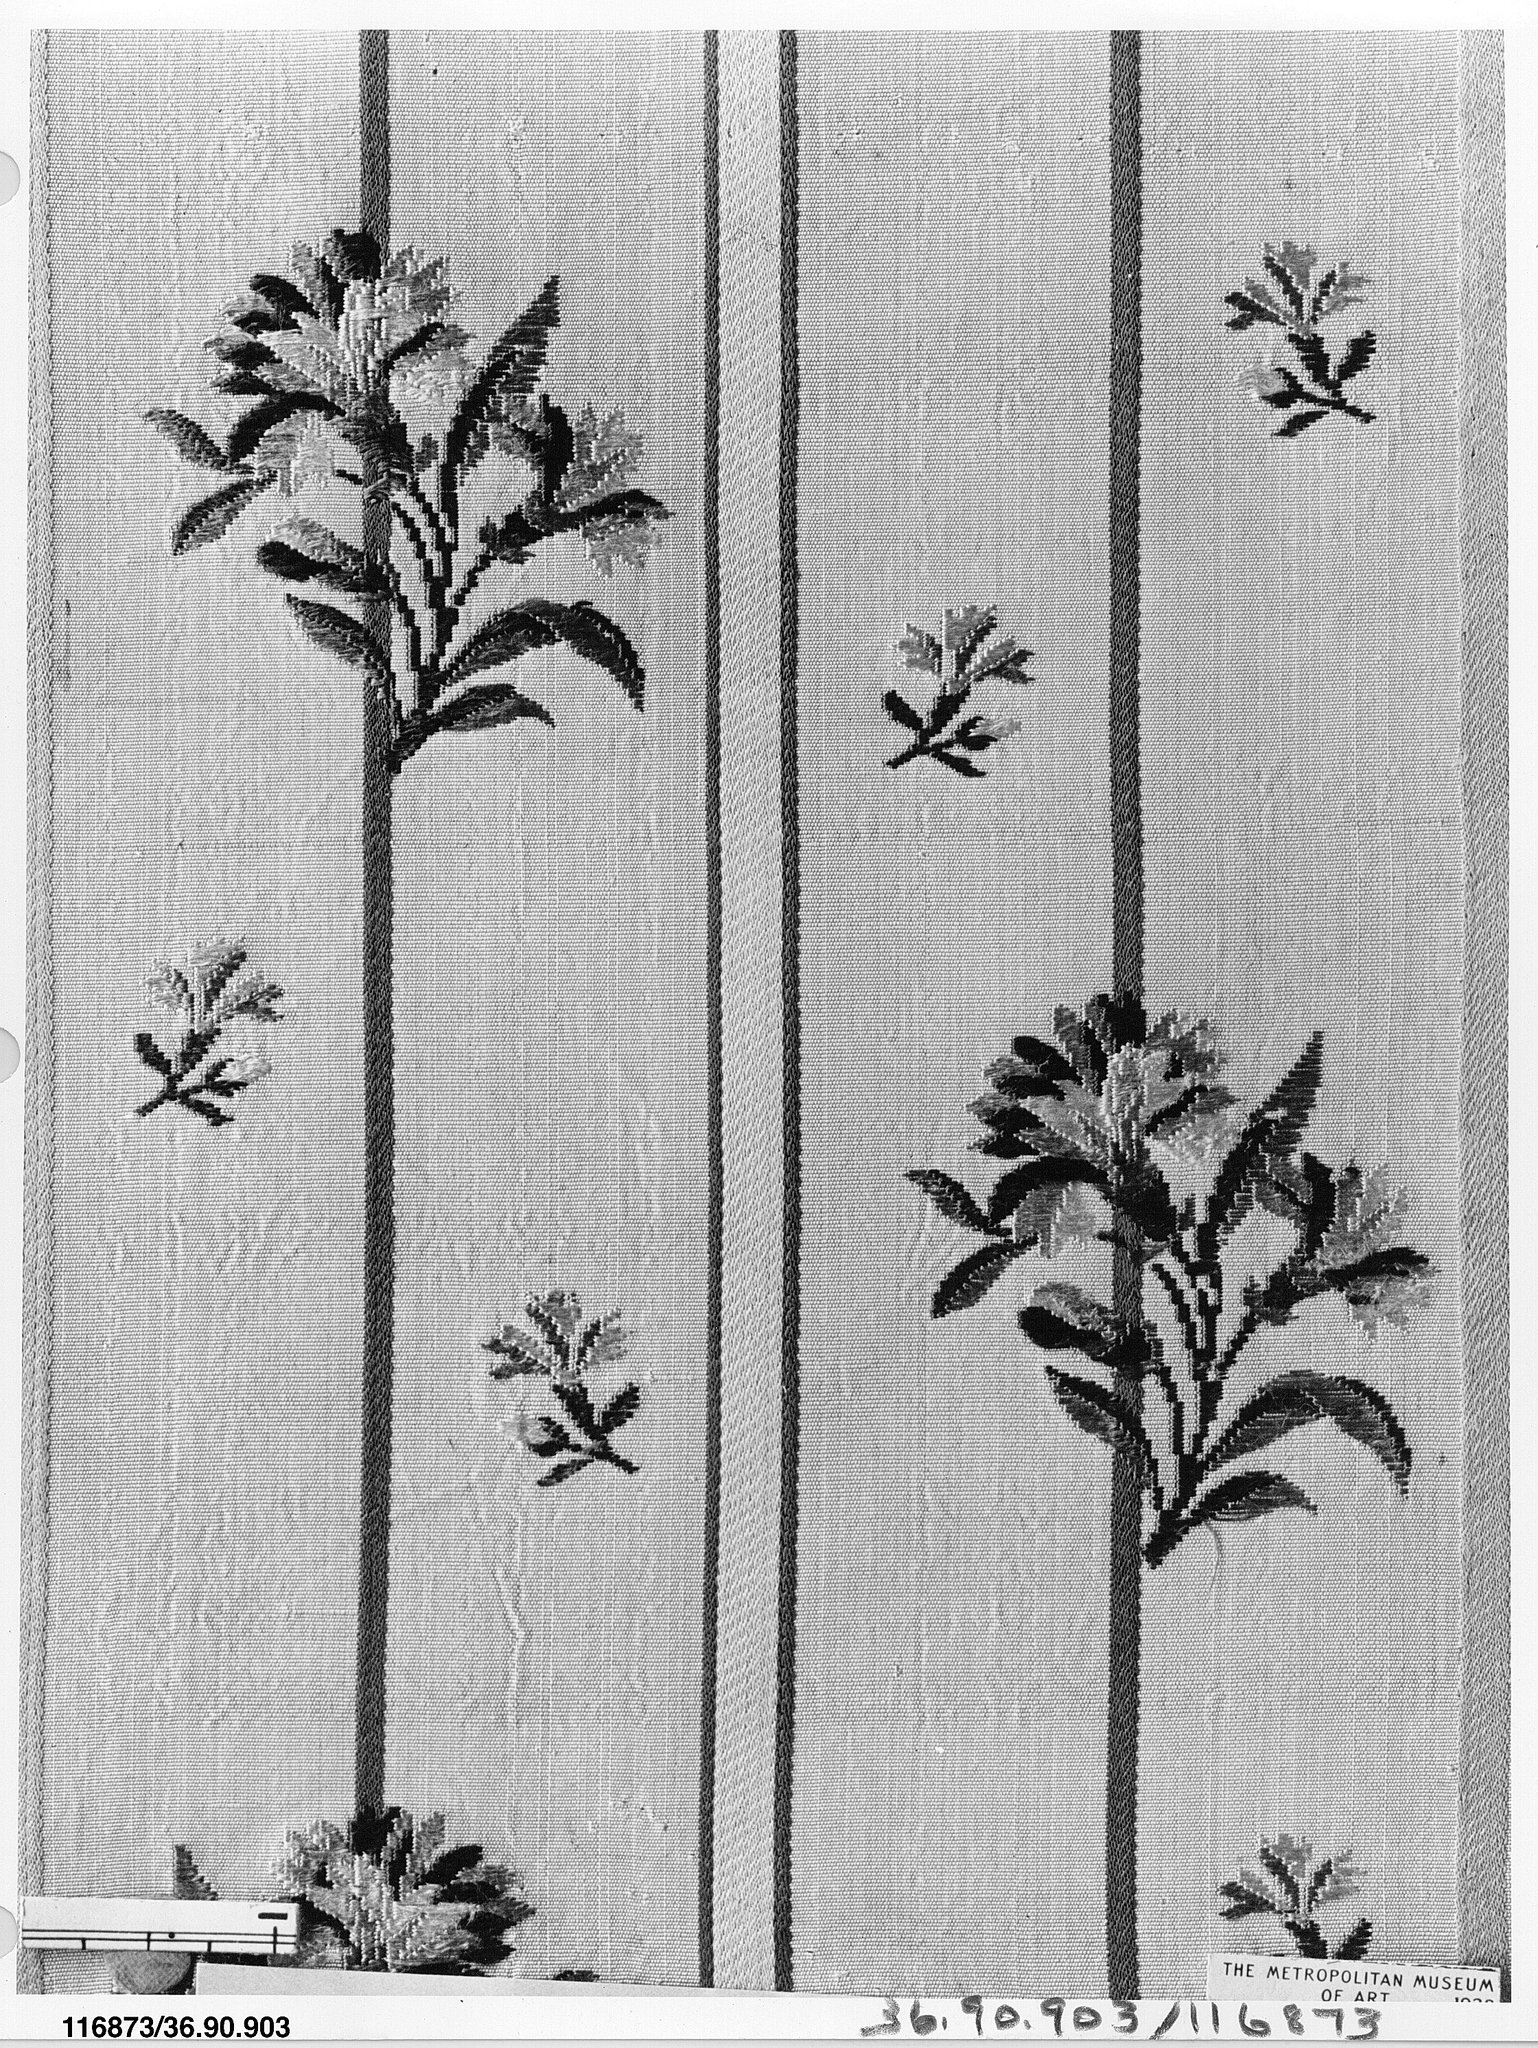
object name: piece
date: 1701-1800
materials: silk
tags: flowers,leaves